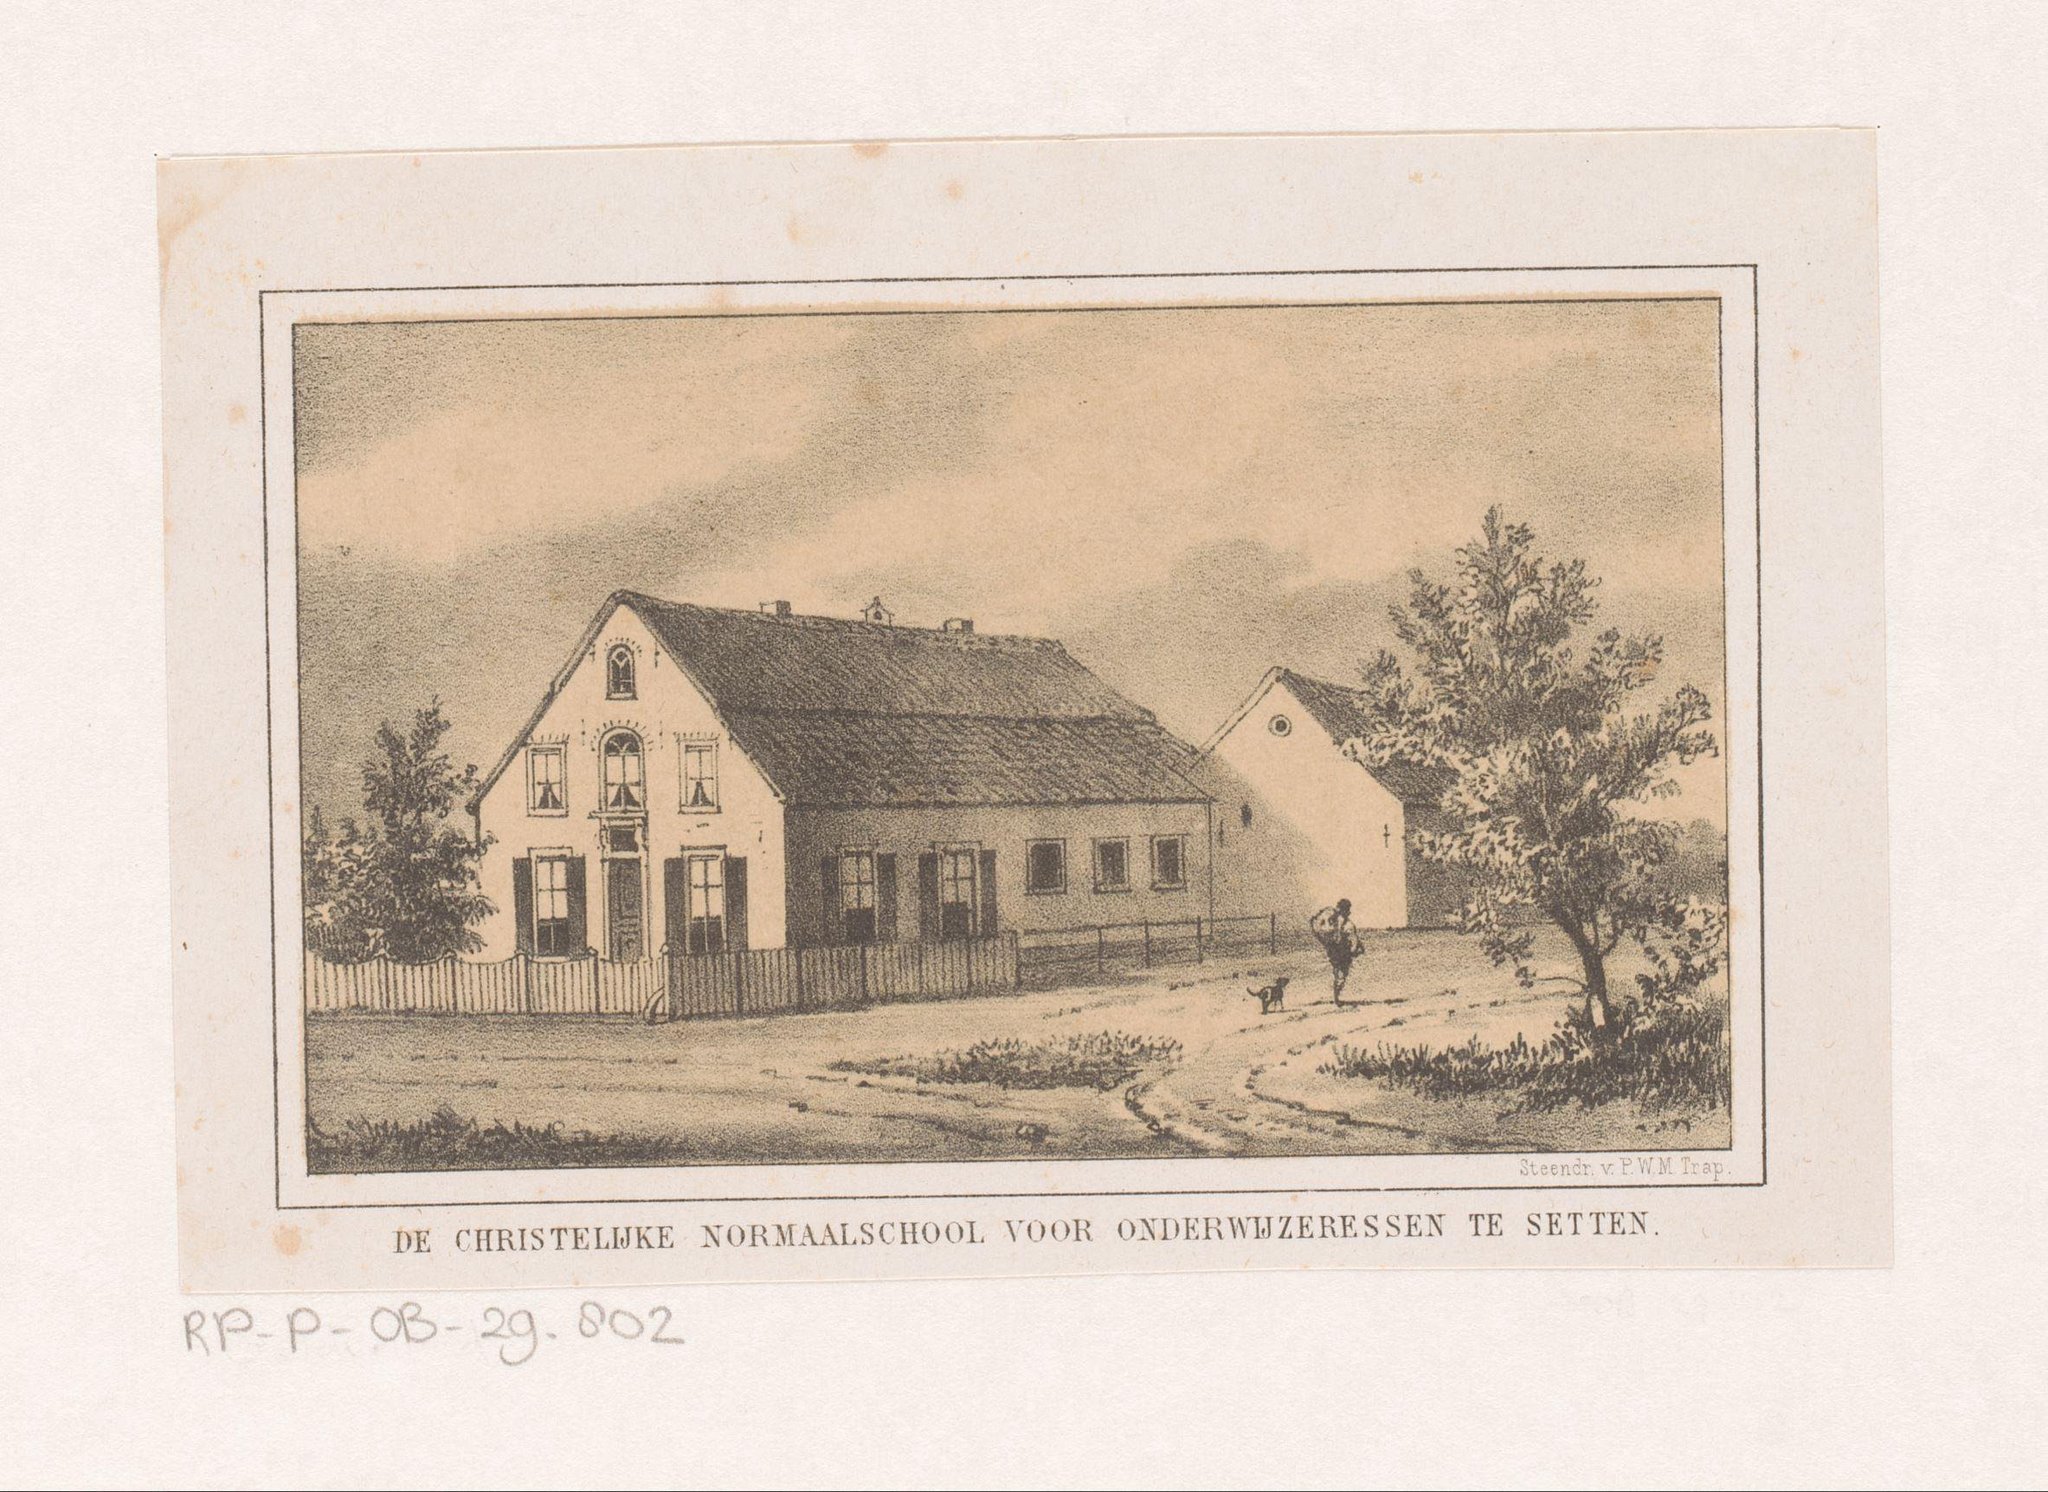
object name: print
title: De Christelijke normaalschool voor onderwijzeressen te Setten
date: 1864-1905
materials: paper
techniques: tone lithography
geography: leiden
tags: scholastic education, tuition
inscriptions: collector's mark: Lugt 2228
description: De in 1864 opgerichte normaalschool te Zetten. Op een pad lopen een man en hond.